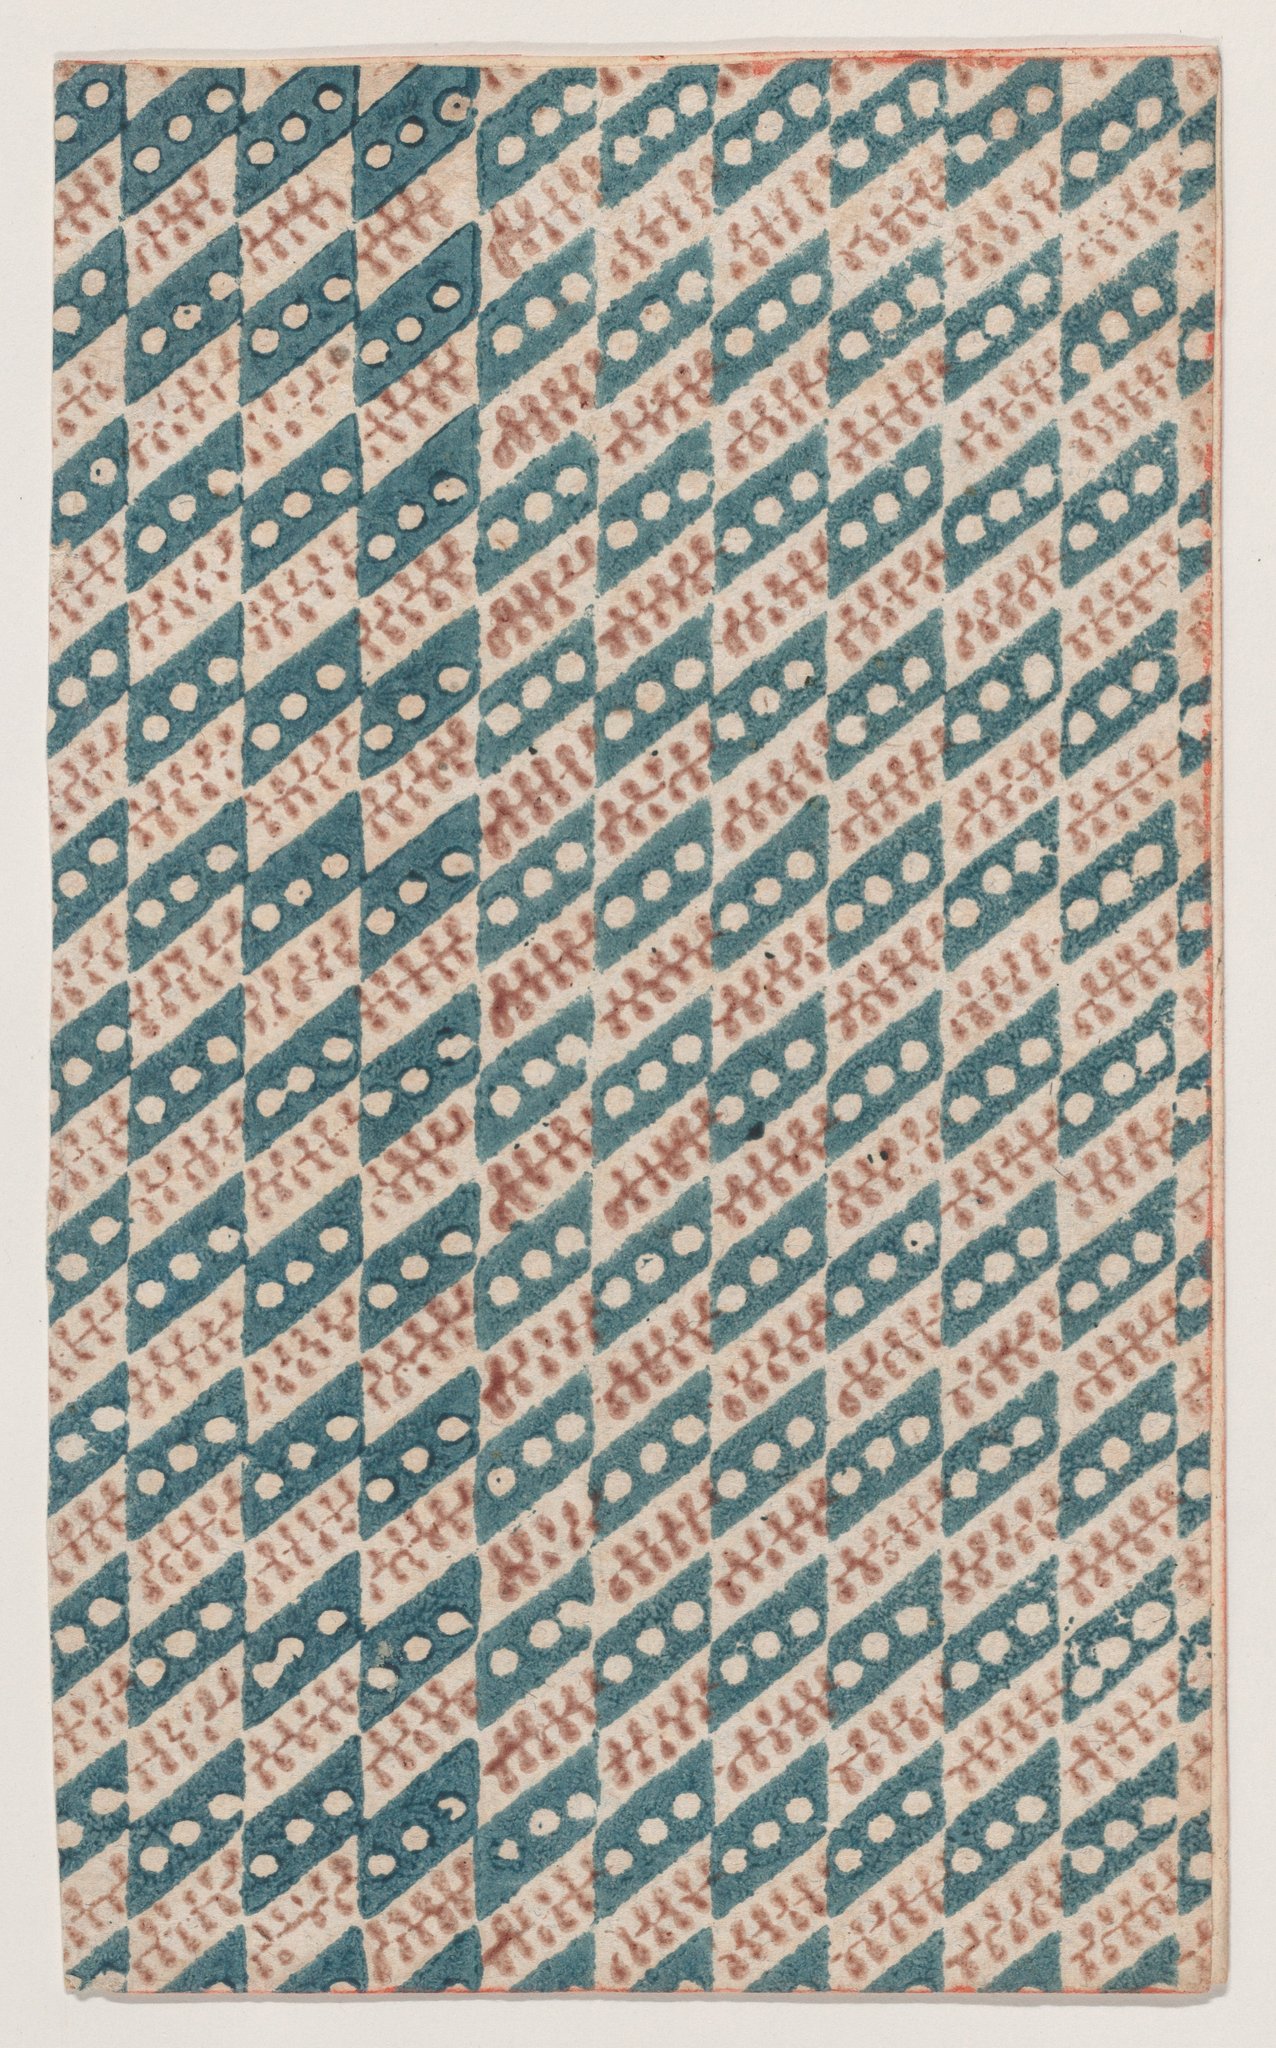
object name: print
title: Sheet with overall zigzag pattern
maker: Anonymous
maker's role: artist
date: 1801-1900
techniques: relief print